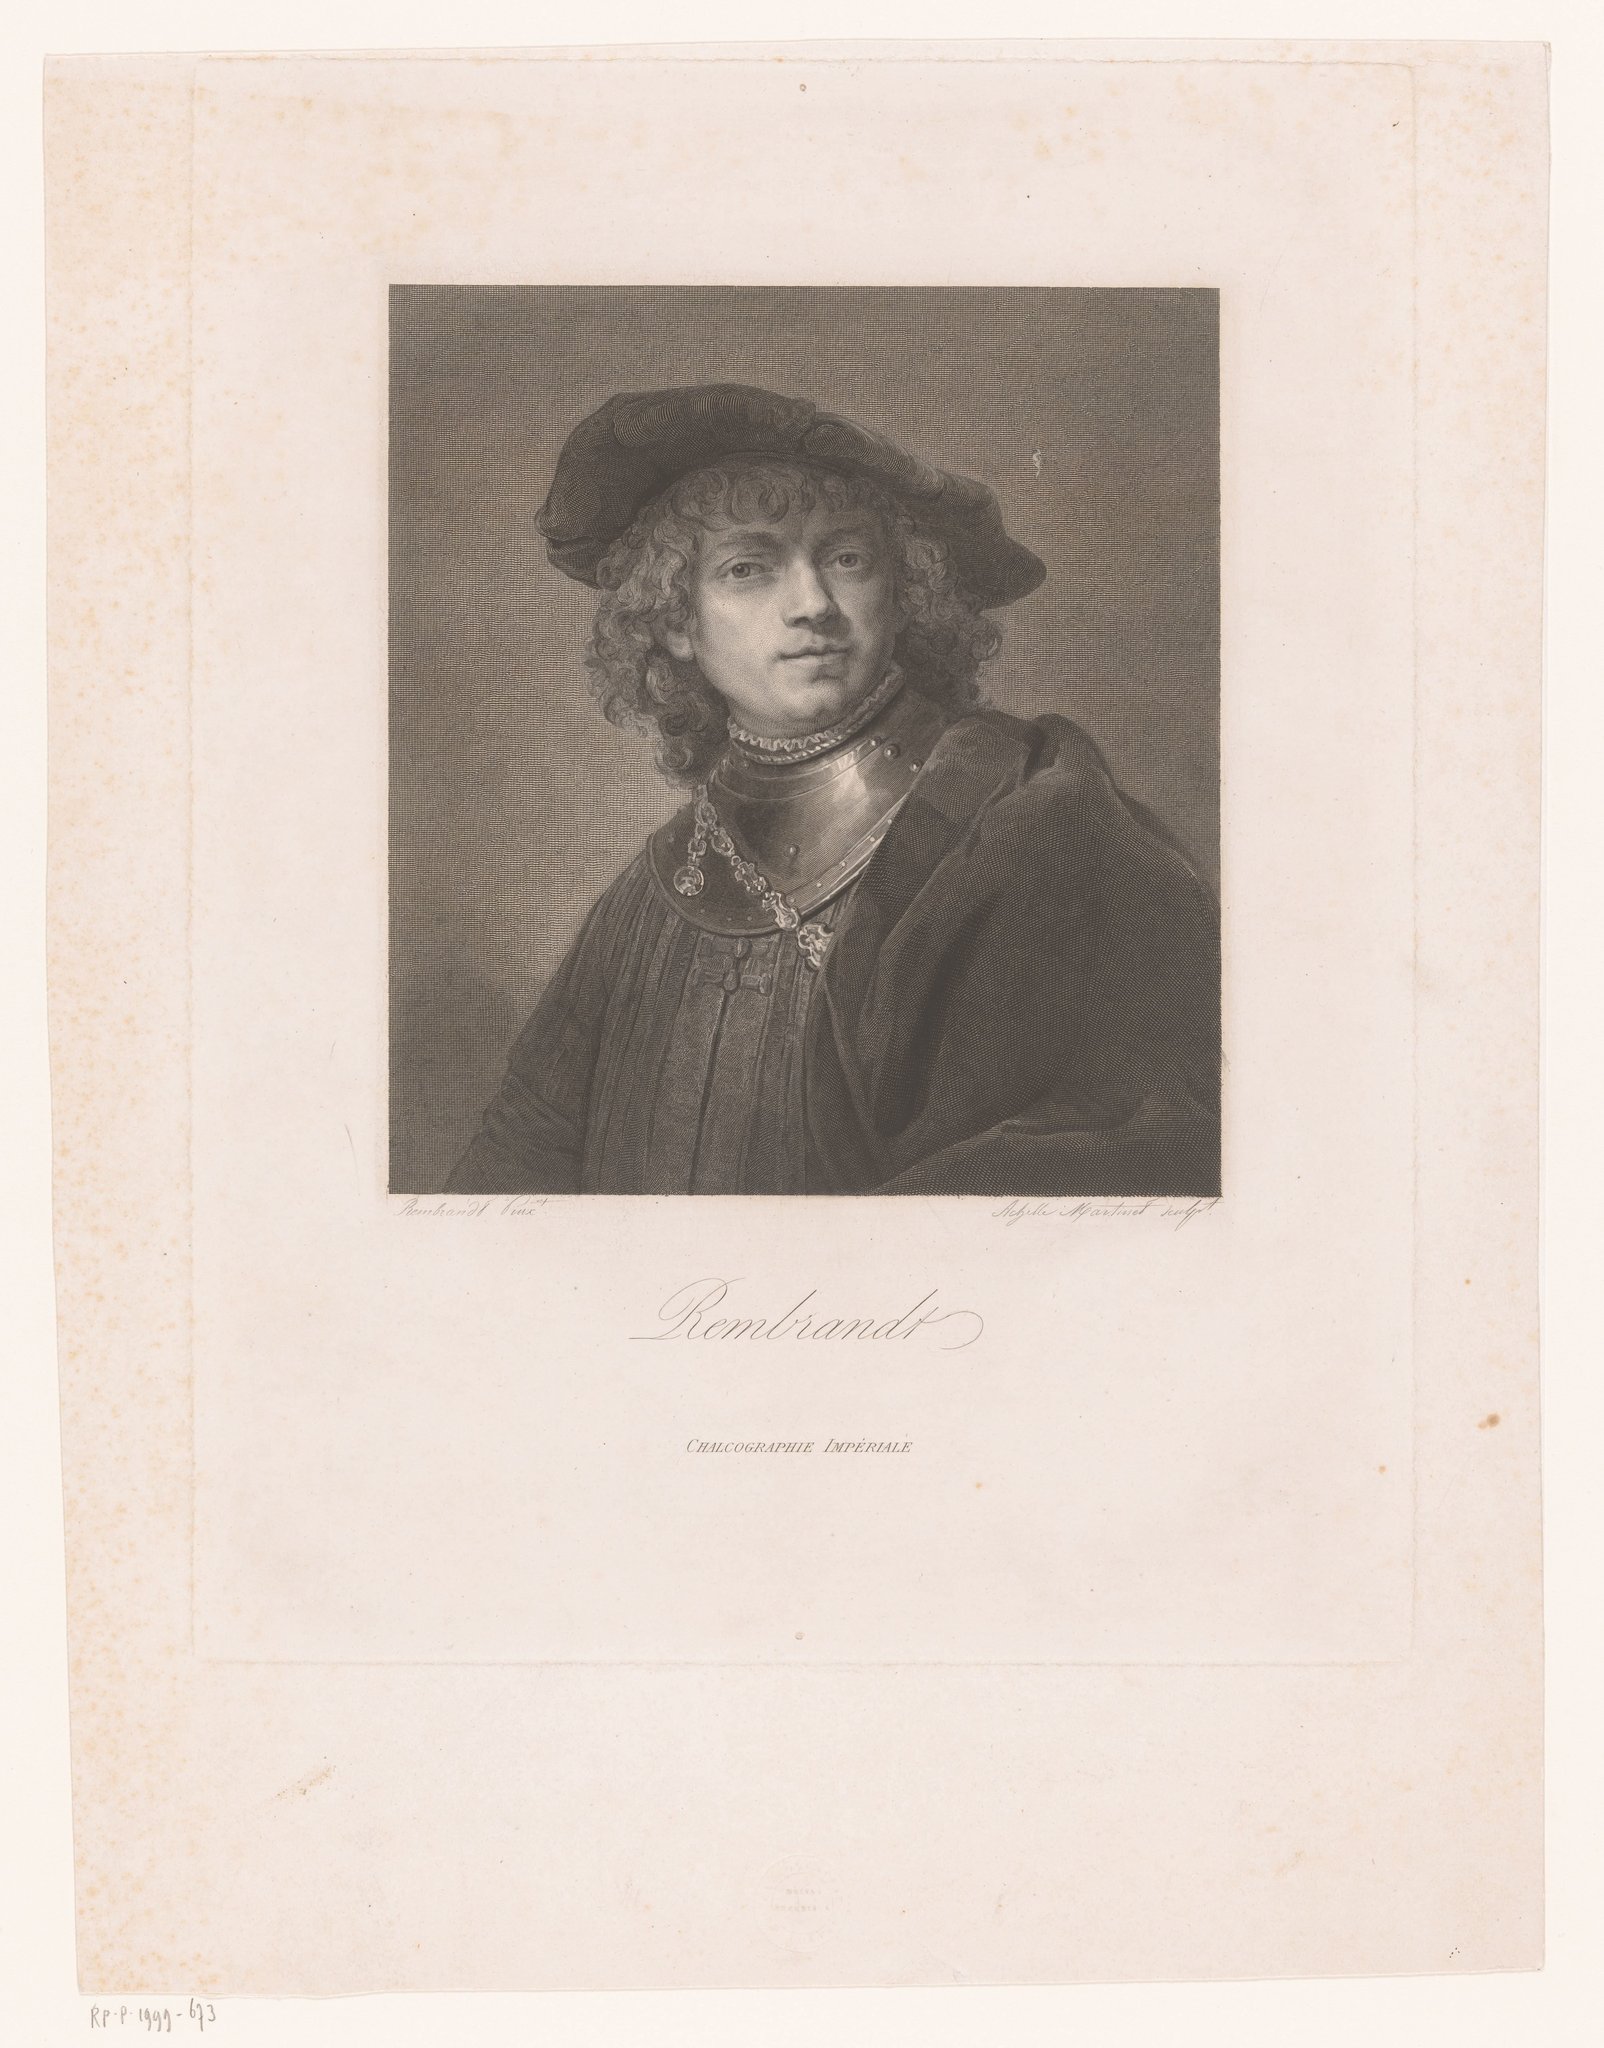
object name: print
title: Rembrandt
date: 1835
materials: paper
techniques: engraving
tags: historical persons, portrait, self-portrait of artist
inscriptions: collector's mark: Lugt 2228, check stamp: ‘Cirkelvormige stempel met in het midden: Musées Imperieux; in de rand: Galgographie Du Louvre.’, collector's mark: Lugt 2760